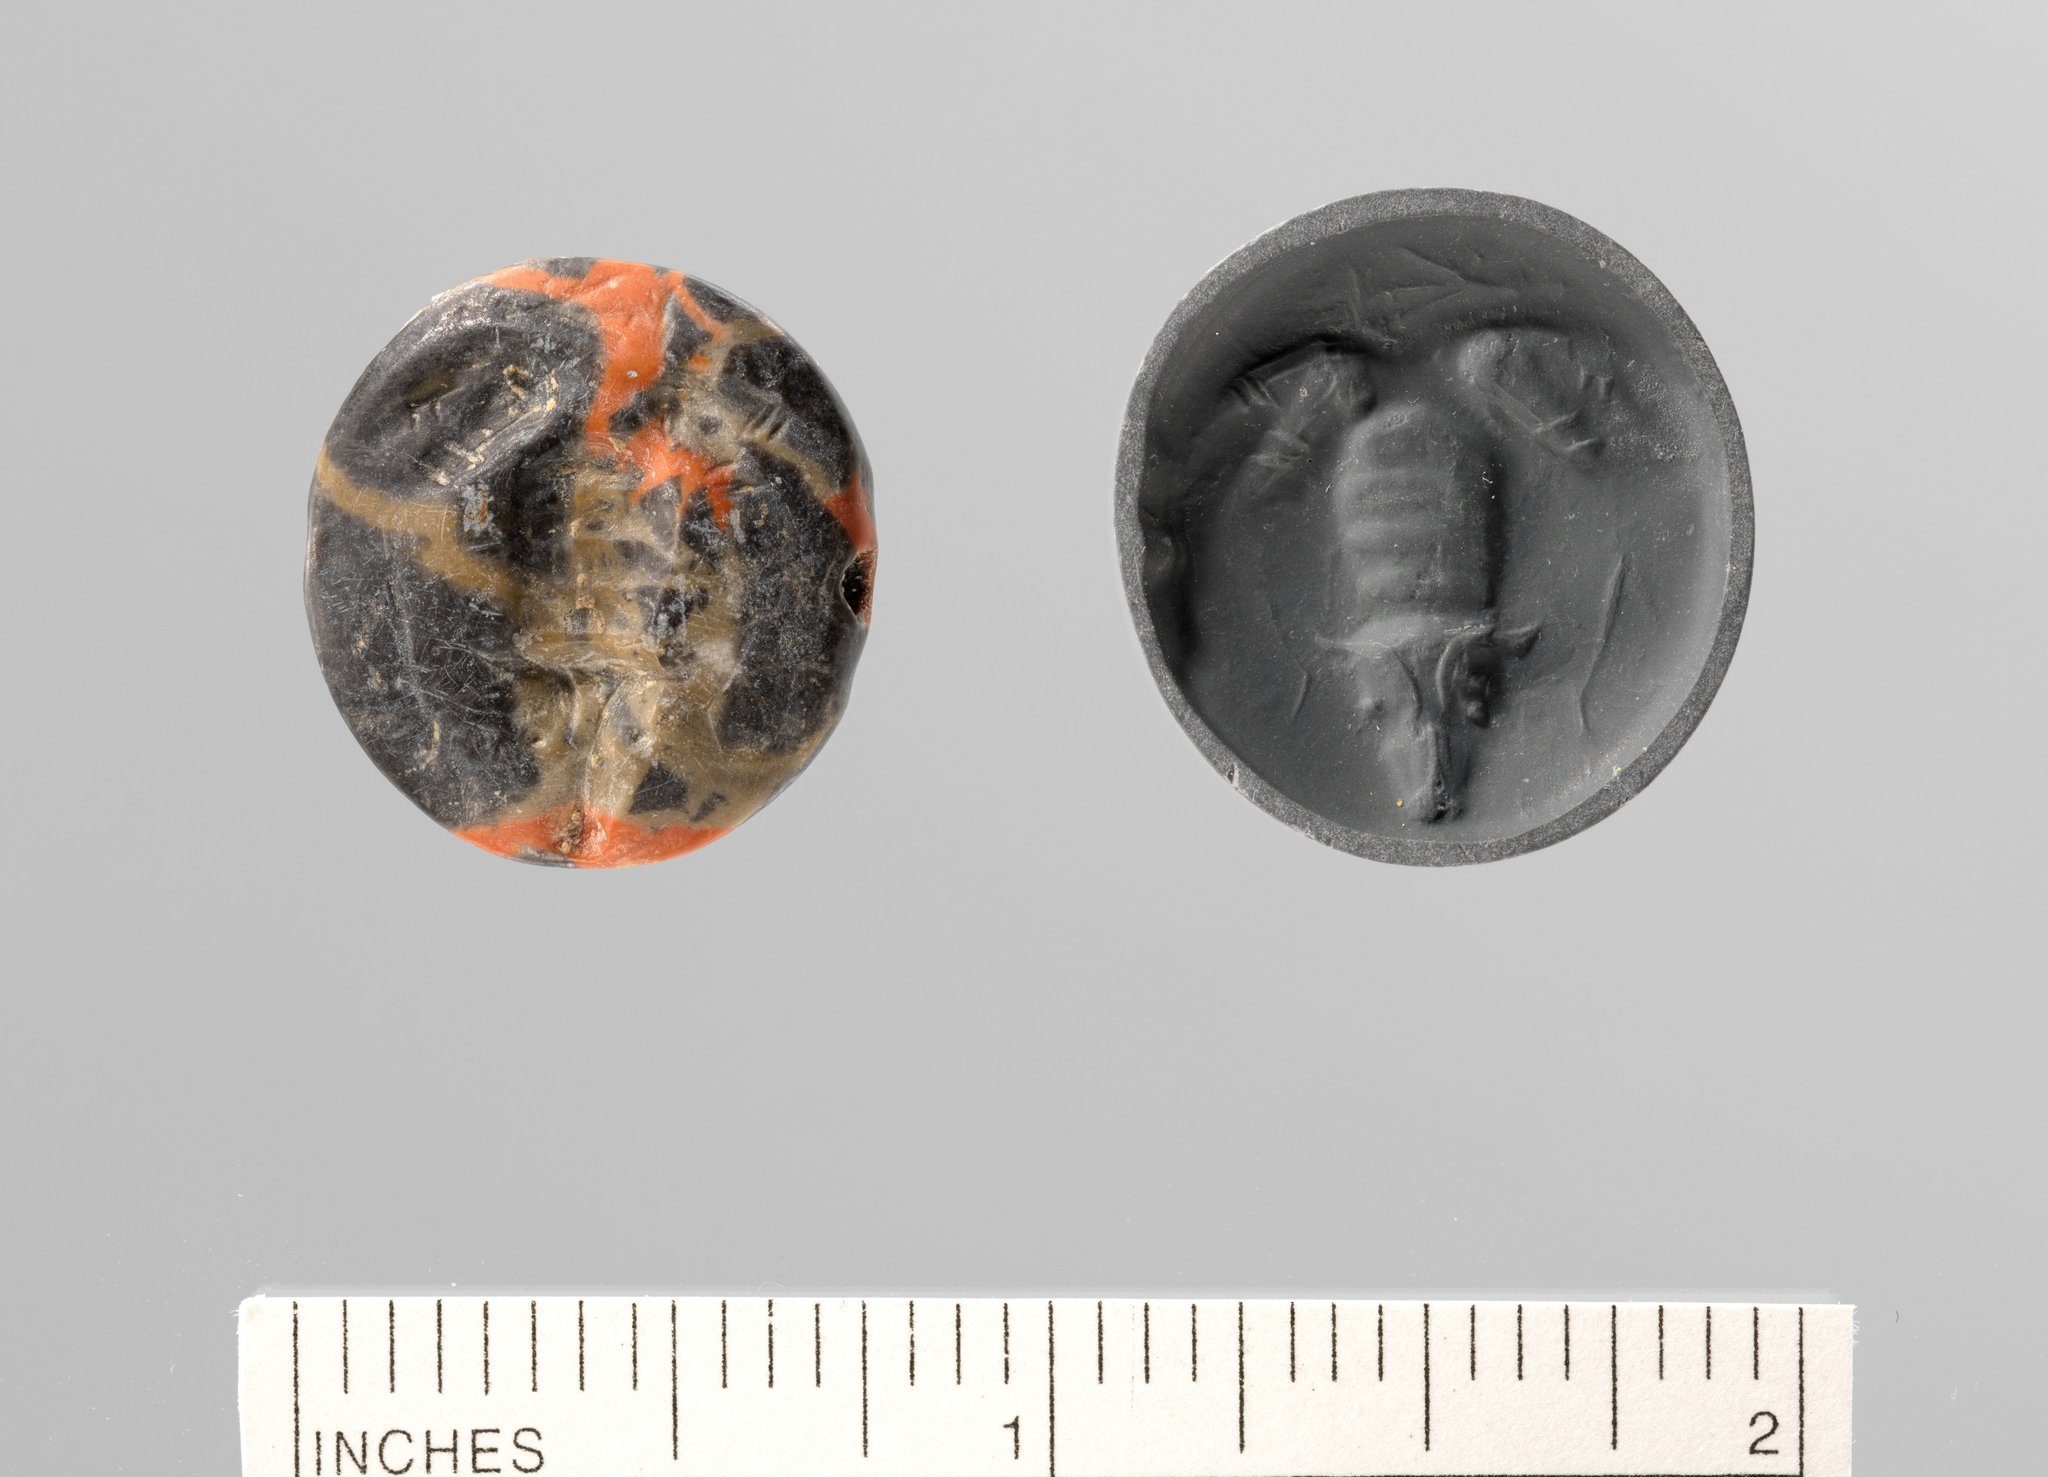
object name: seal, lentoid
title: Jasper Lentoid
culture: minoan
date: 1400-1375 BCE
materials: jasper